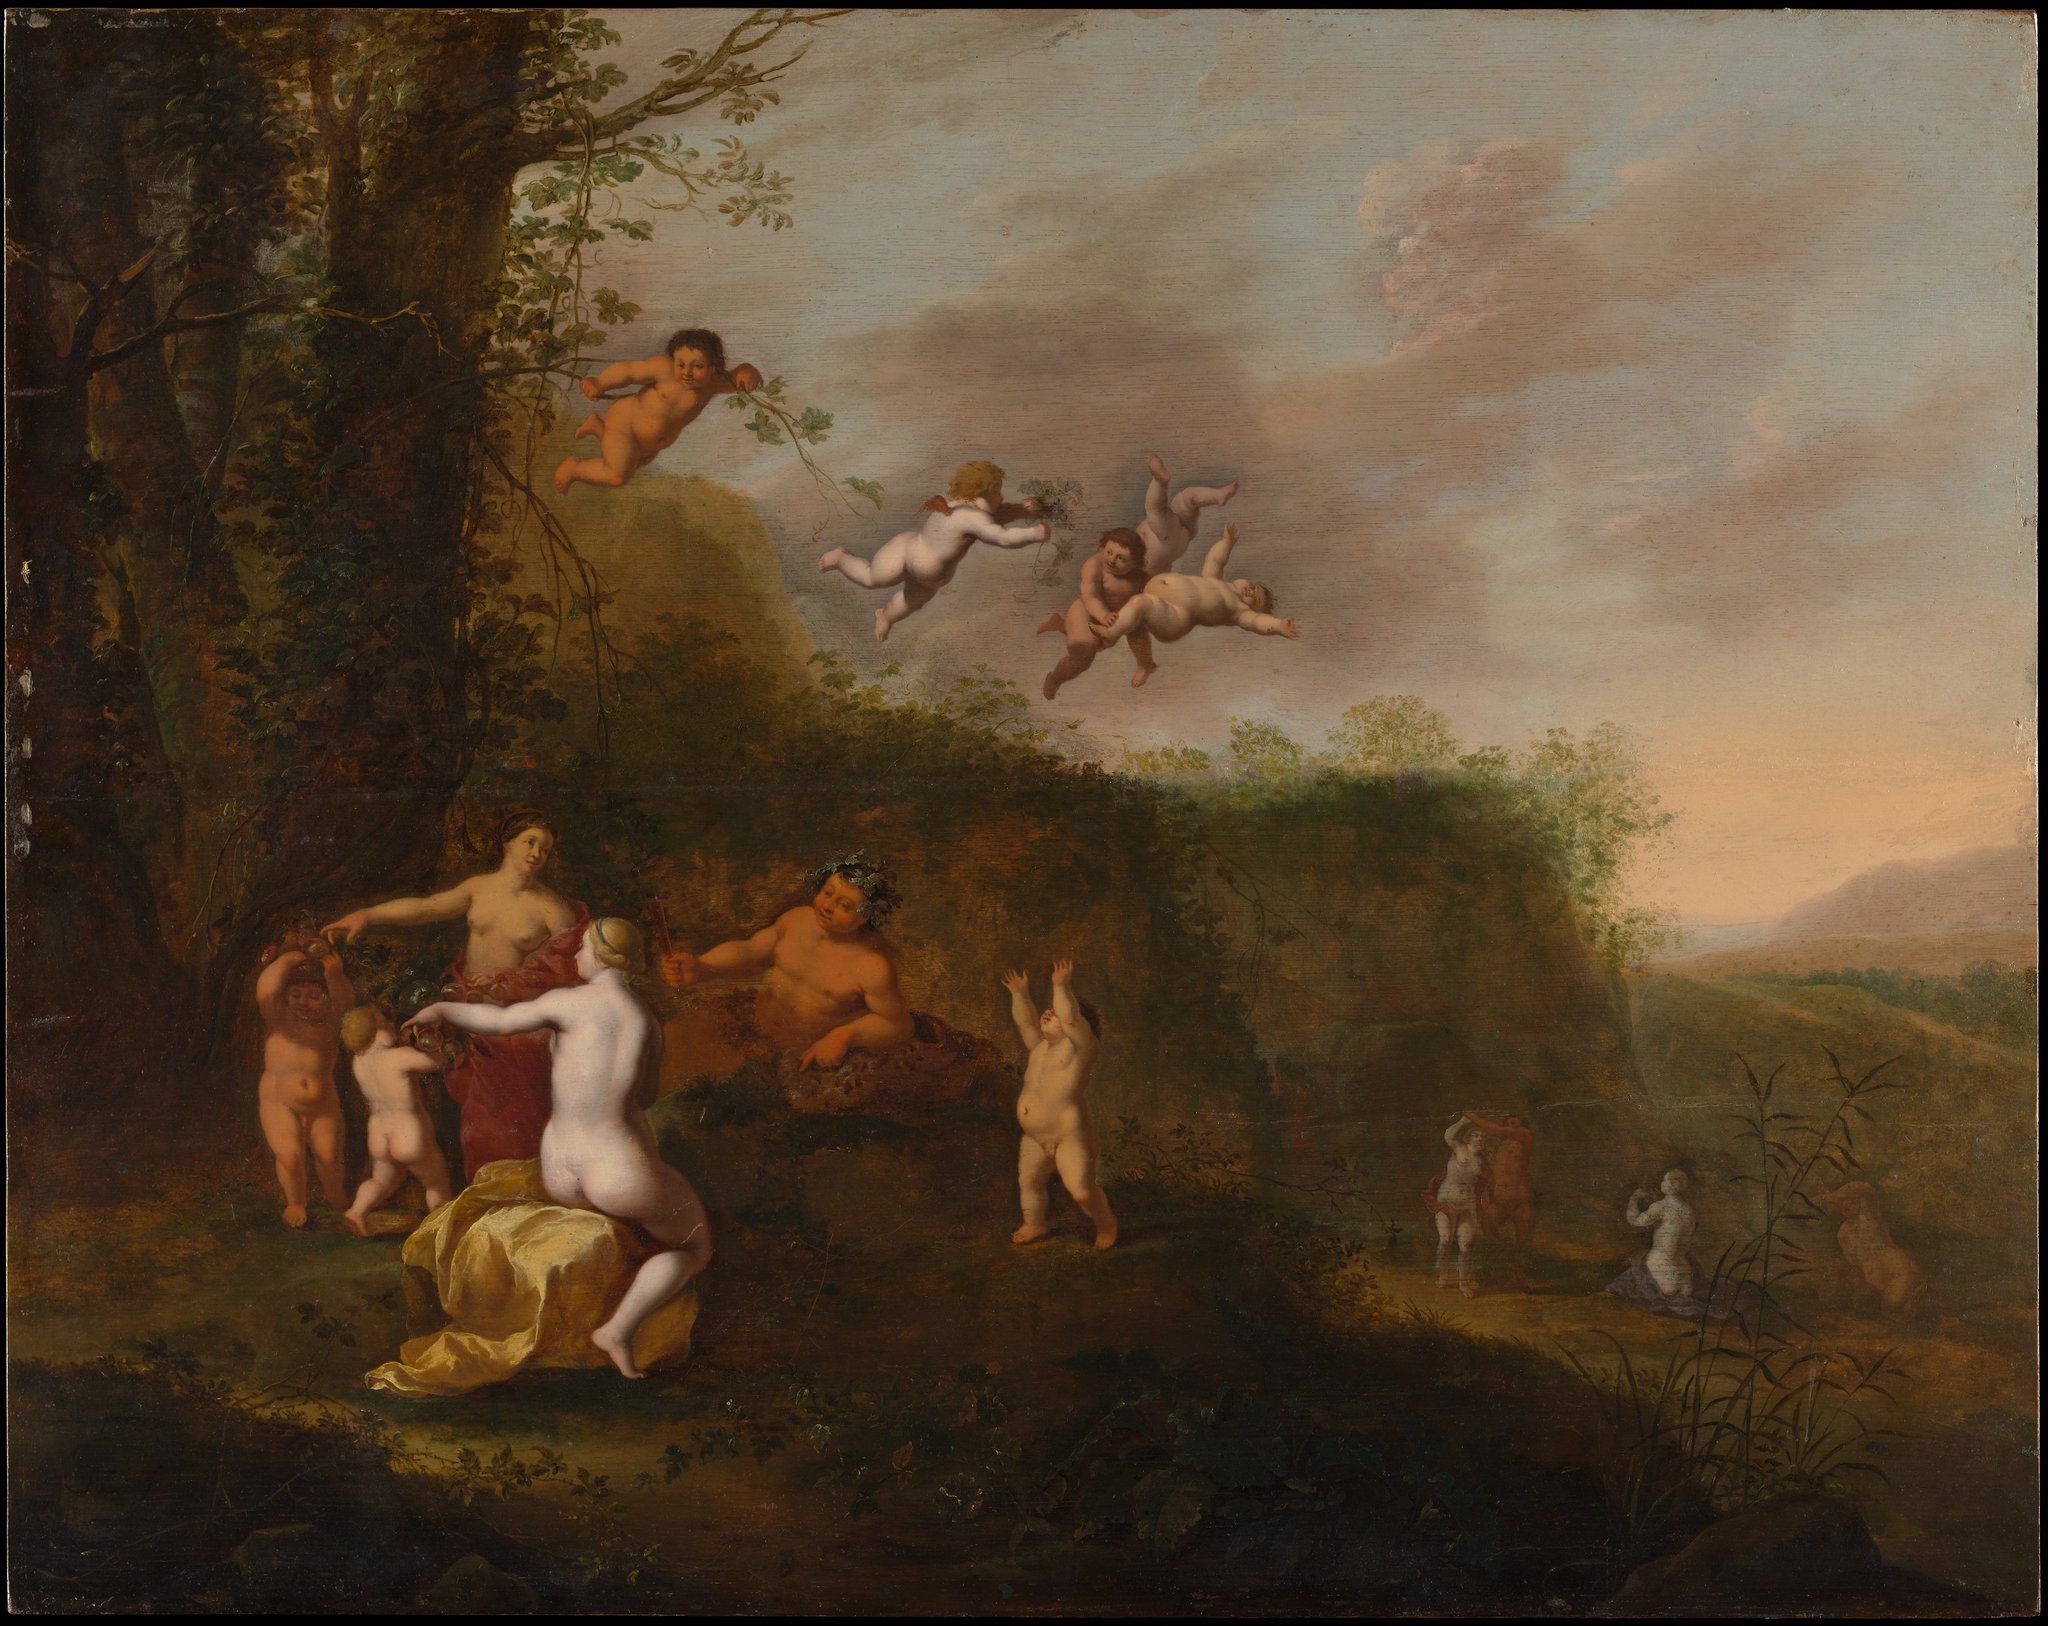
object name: painting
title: Bacchus and Nymphs in a Landscape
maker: abraham van cuylenborch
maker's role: artist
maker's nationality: dutch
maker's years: 1620-1658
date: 1640-1649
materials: oil, wood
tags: nymphs,putti,bacchus,landscapes